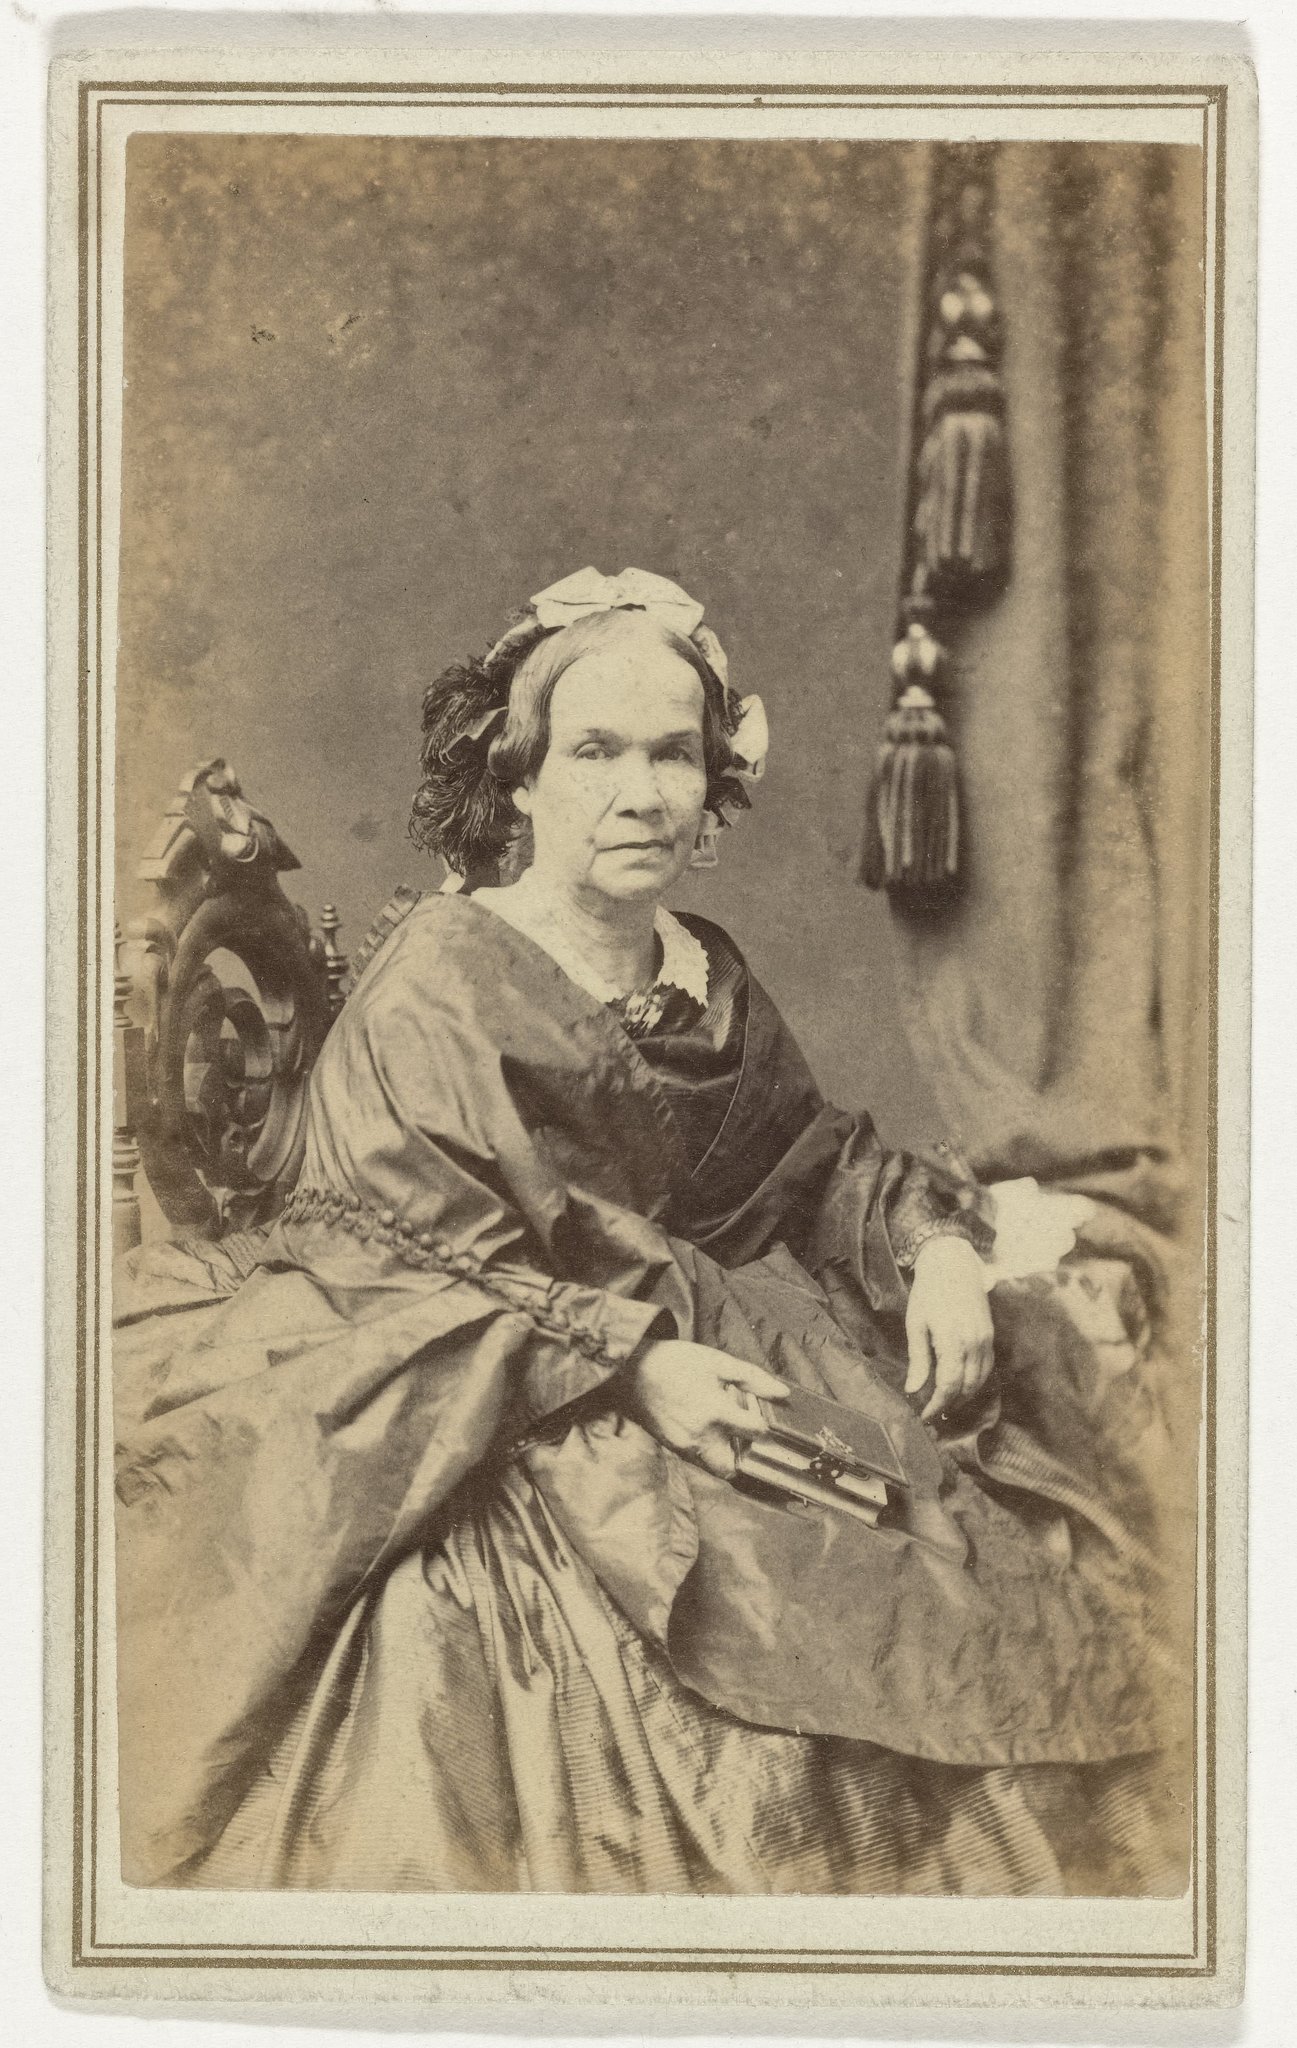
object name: carte de visite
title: Portret van vermoedelijk Jacqueline Frederika Robles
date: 1863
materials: photographic support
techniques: photography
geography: suriname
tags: suriname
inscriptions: annotation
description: Portret van een vrouw, vermoedelijk Jacqueline Frederika Robles. Zittend, boek in de hand. Onderdeel van een groep objecten afkomstig van de familie Wesenhagen in Suriname.